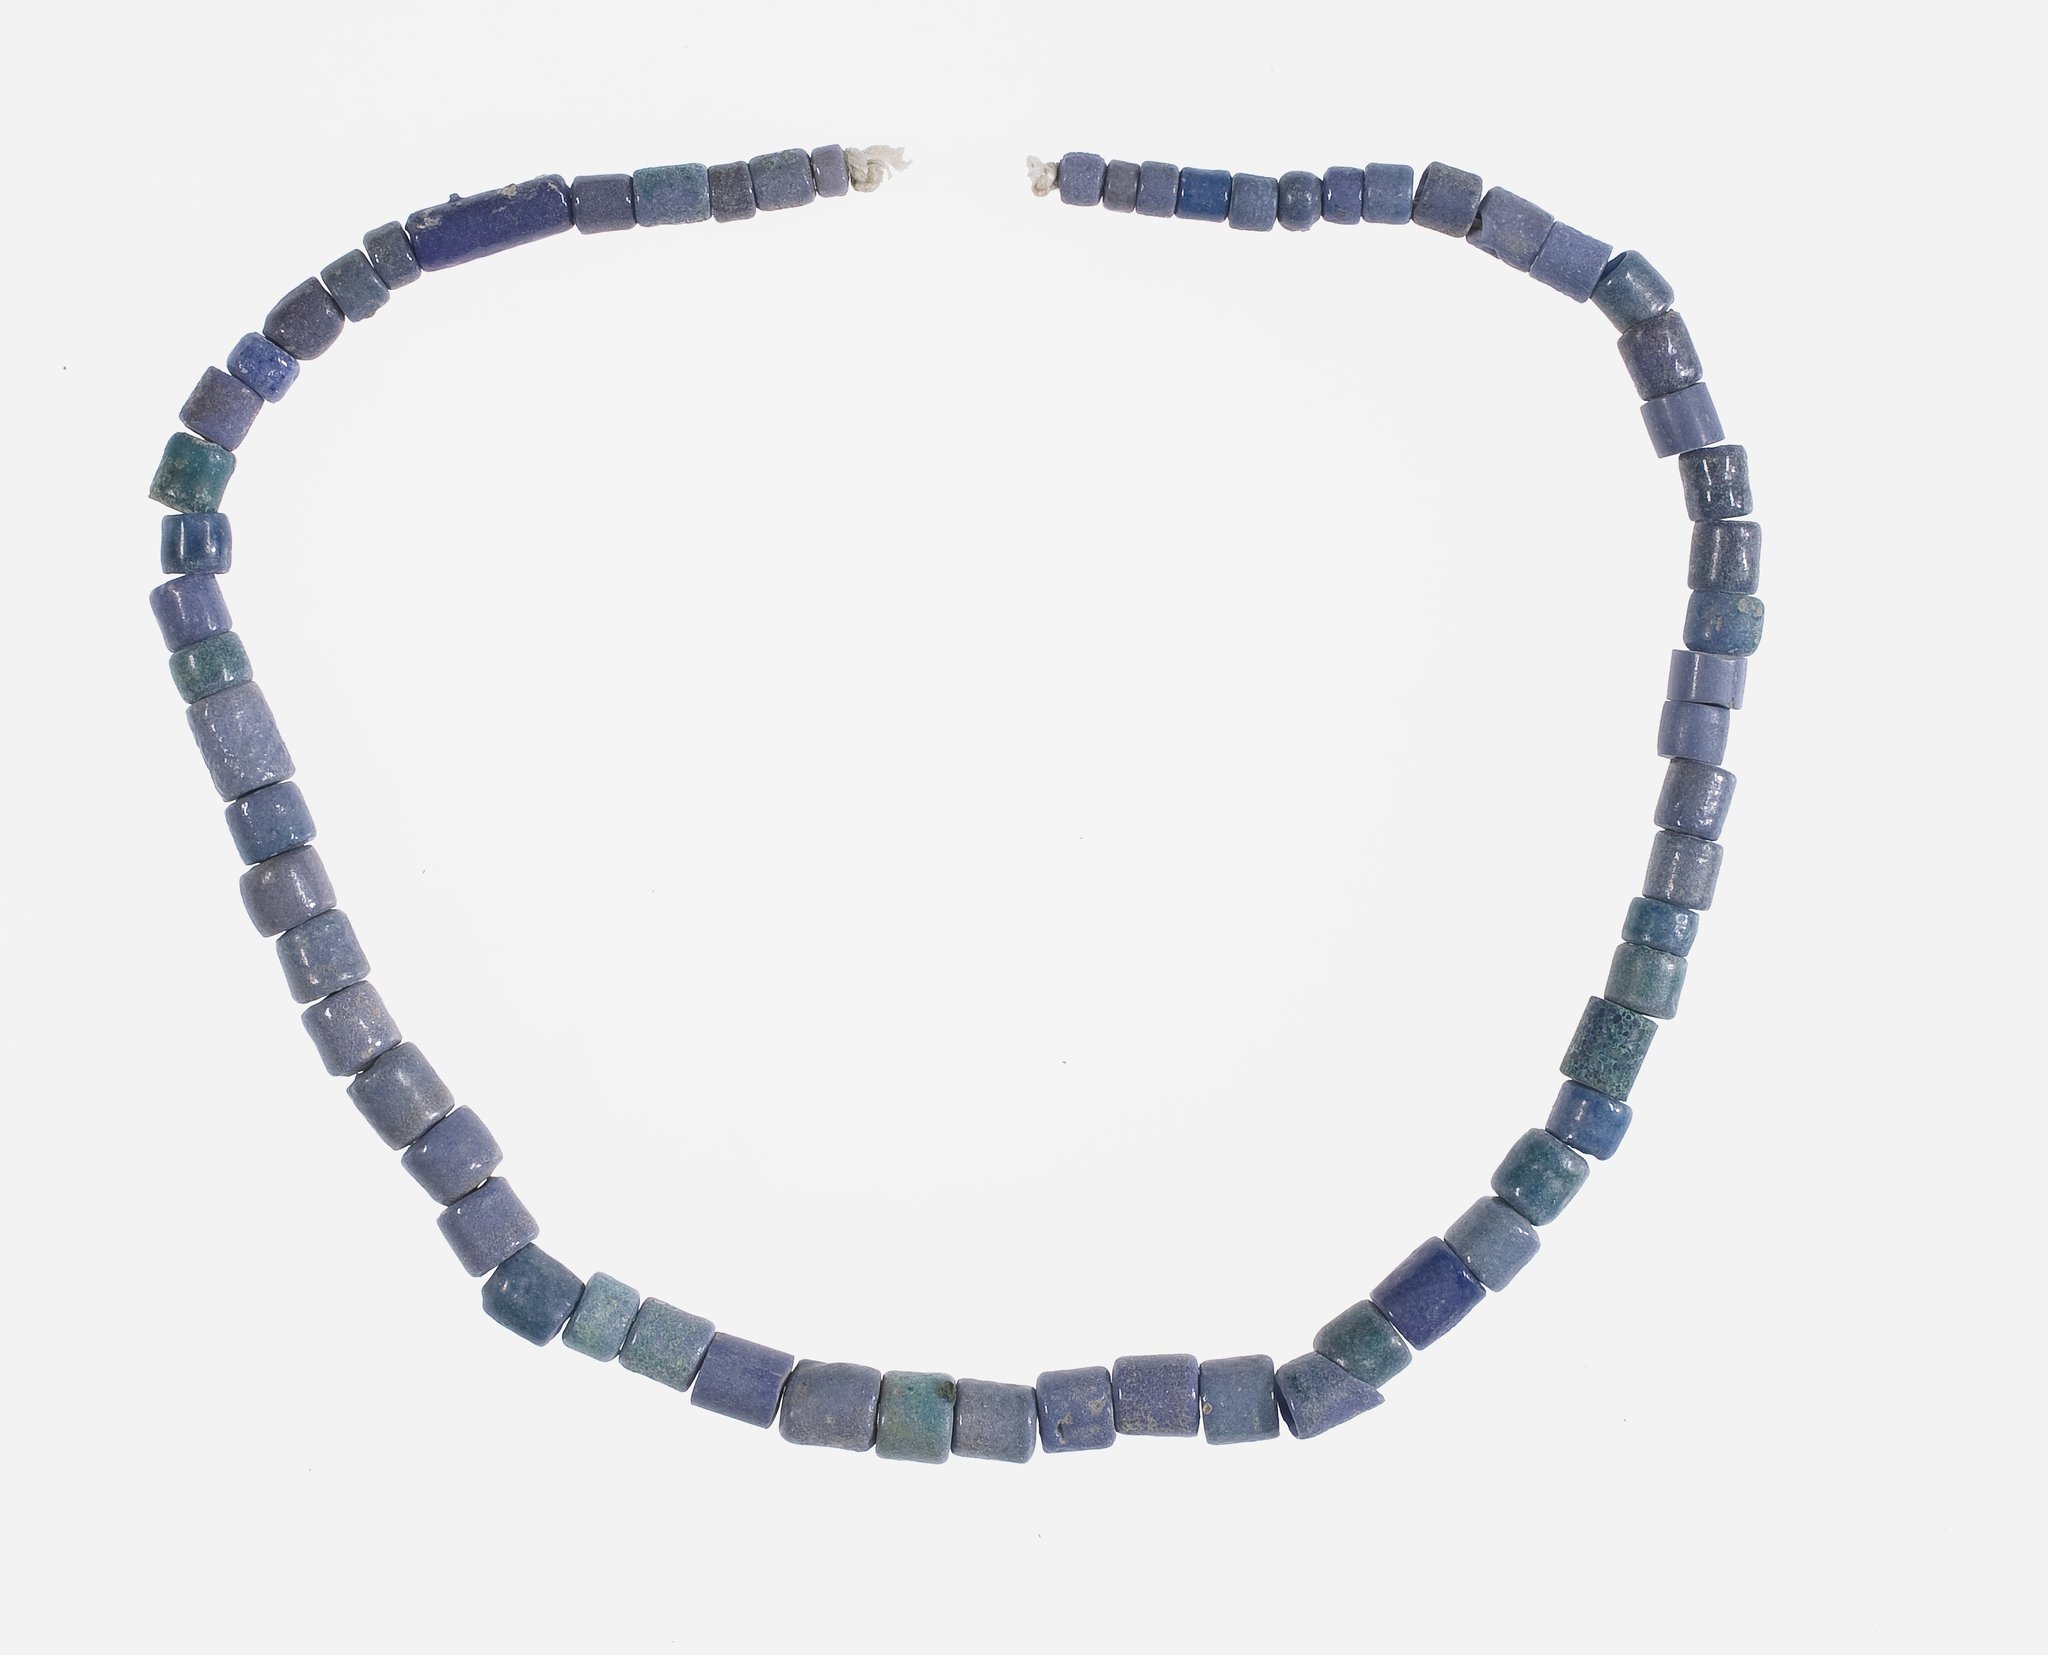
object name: bead, cylinder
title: String of Short Cylindrical Beads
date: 1390-1352 BCE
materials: faience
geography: egypt